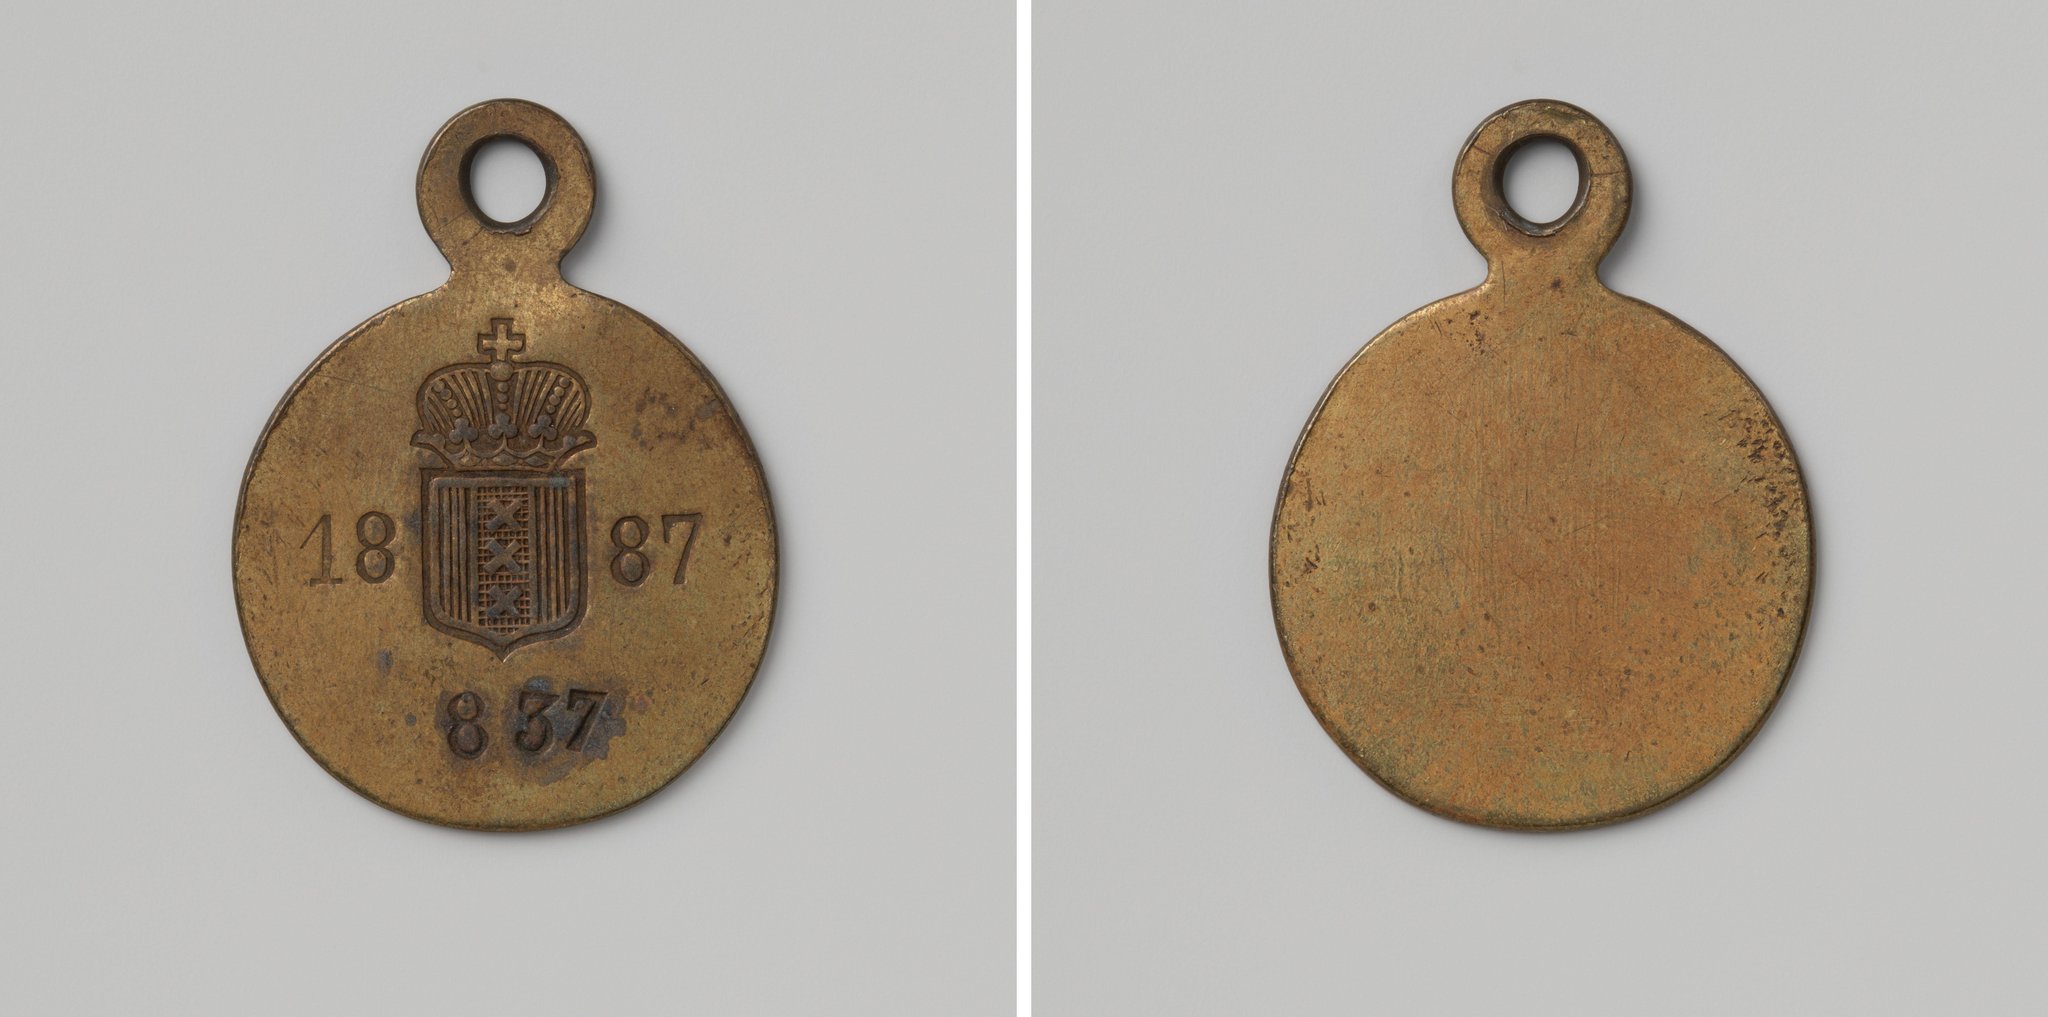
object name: hondenbelastingloodje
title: Stad Amsterdam, loodje met no. 837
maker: Anonymous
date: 1887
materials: brass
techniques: striking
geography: amsterdam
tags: amsterdam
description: eenzijdig loodje aan draagoog. Voorzijde: gekroond wapenschild tussen jaartal boven cijfer 837. Keerzijde: blanco